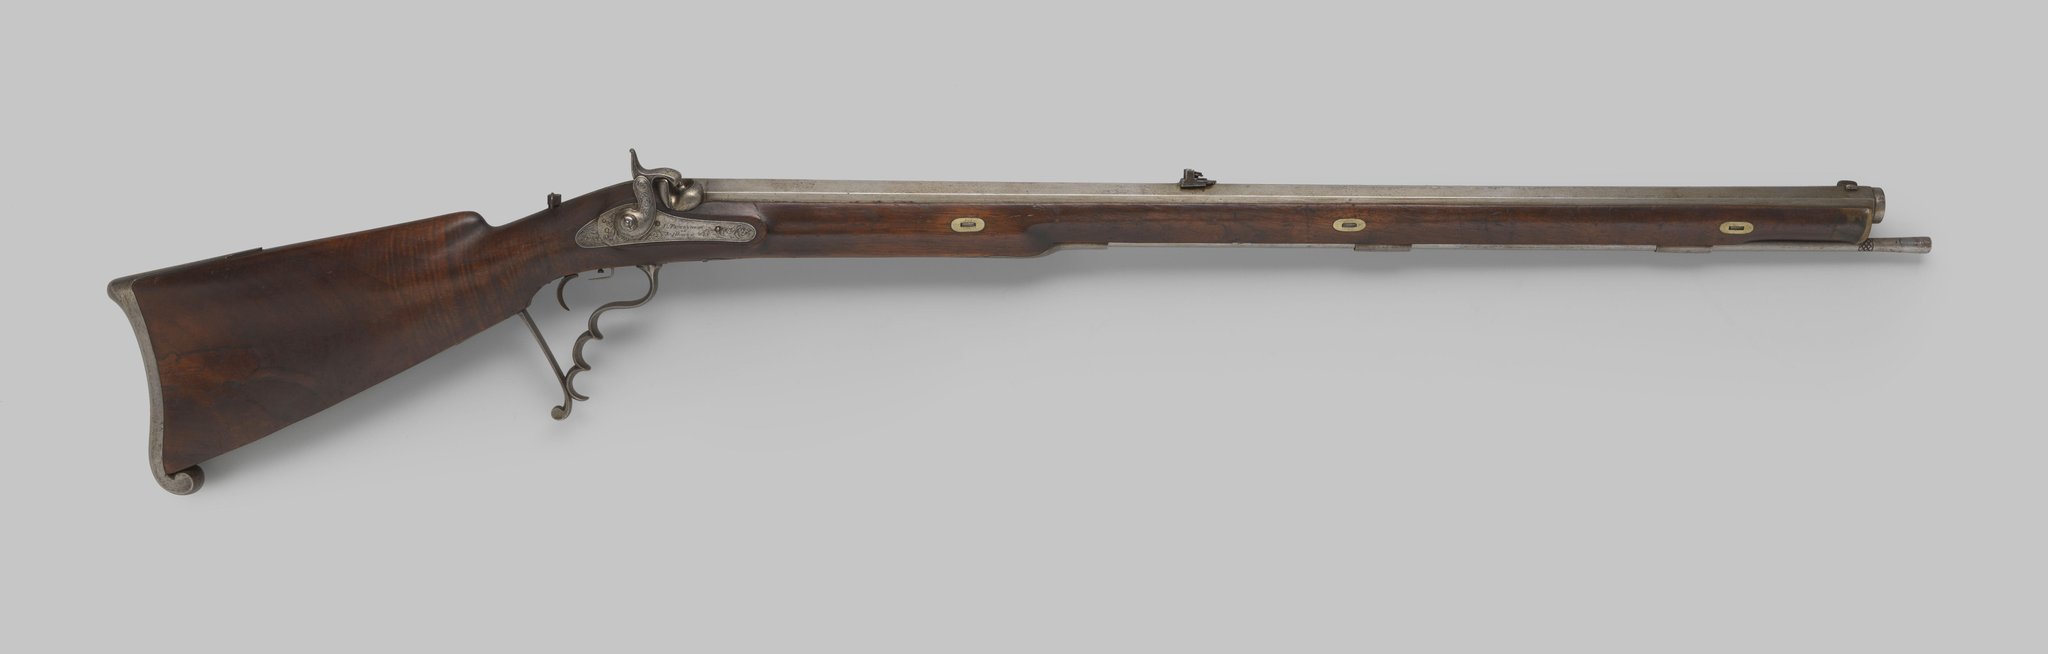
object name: air rifle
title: Buks met achtkantige loop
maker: Anonymous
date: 1700-1900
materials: iron, wood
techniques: engraving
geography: europe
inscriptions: : ‘L. Teutenberg in Hüsten’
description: Voorlaad, zeven velden en zeven trekken. Het slot is met graveerwerk versierd. De buks is gemerkt 'L. Teutenberg in Hüsten'.